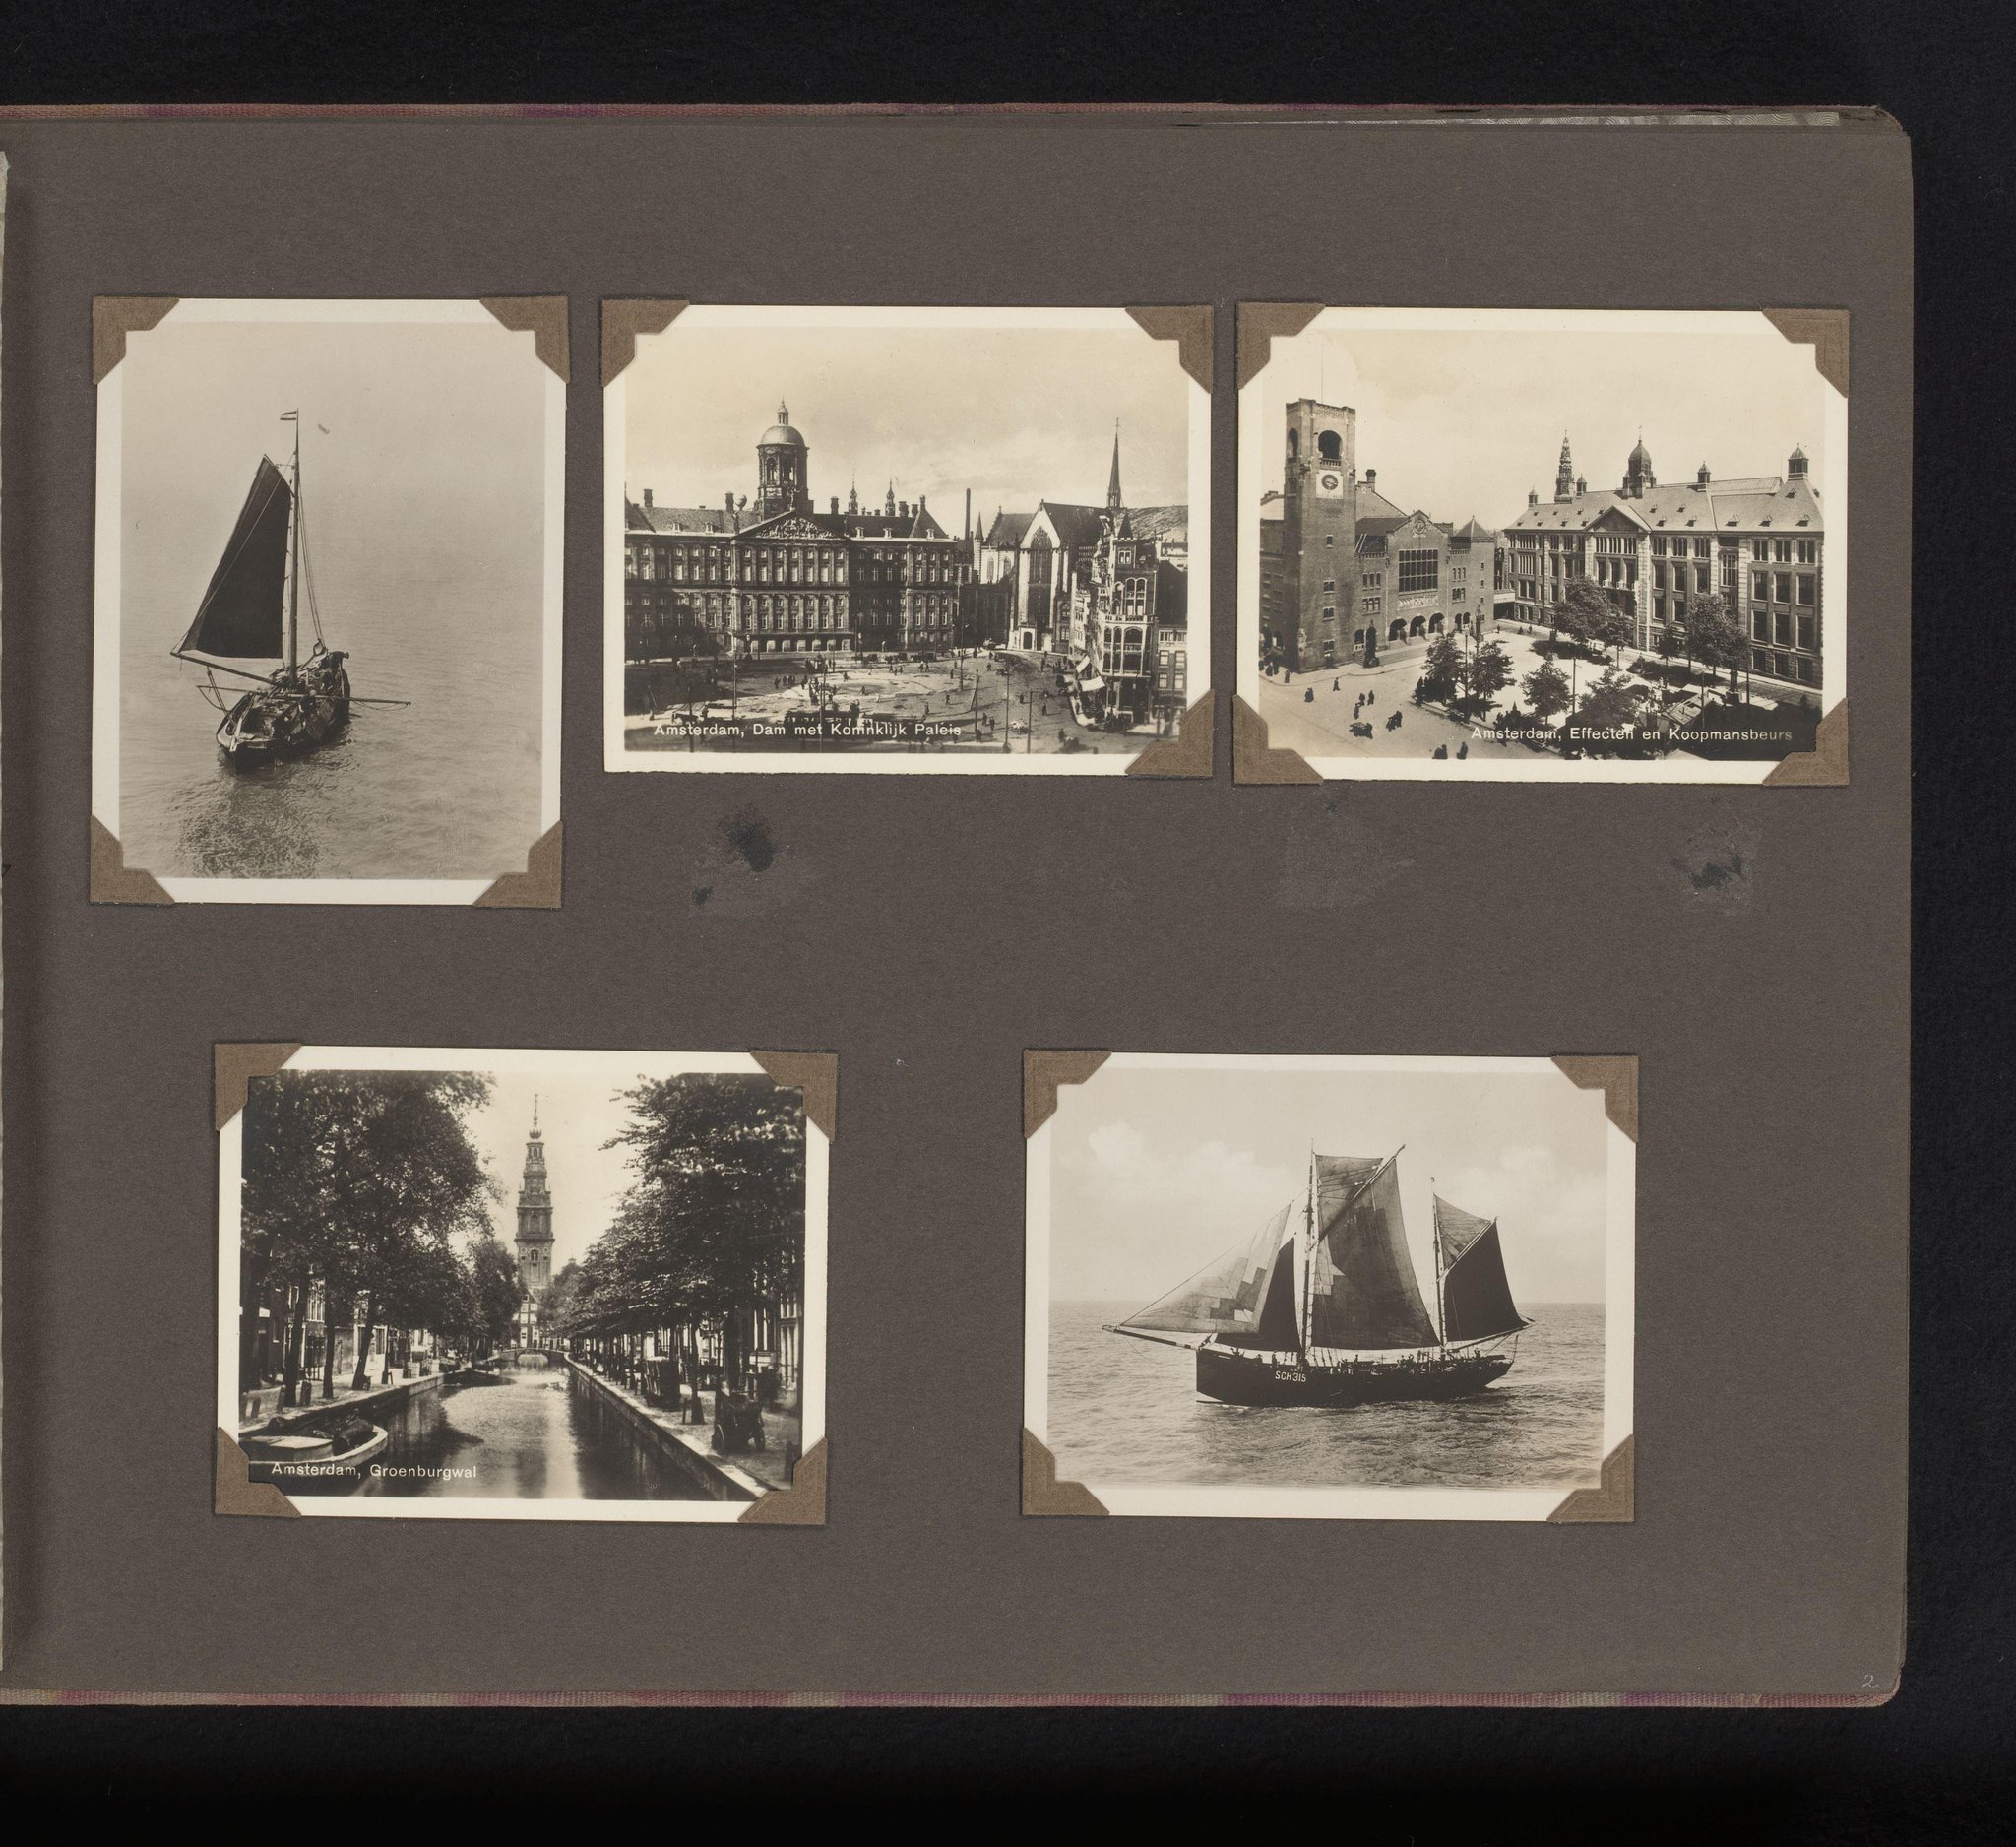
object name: photograph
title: Drie gezichten op Amsterdam en twee afbeeldingen van zeilschepen op zee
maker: Anonymous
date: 1930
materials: cardboard, photographic support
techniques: gelatin silver print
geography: netherlands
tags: sailing-ship, sailing-boat, prospect of city, town panorama, silhouette of city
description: In de opschriften van de gezichten op Amsterdam is vermeld dat het gaat om de Dam, de Beurs van Berlage en de Groenburgwal. Deze foto's maken deel uit van een album.